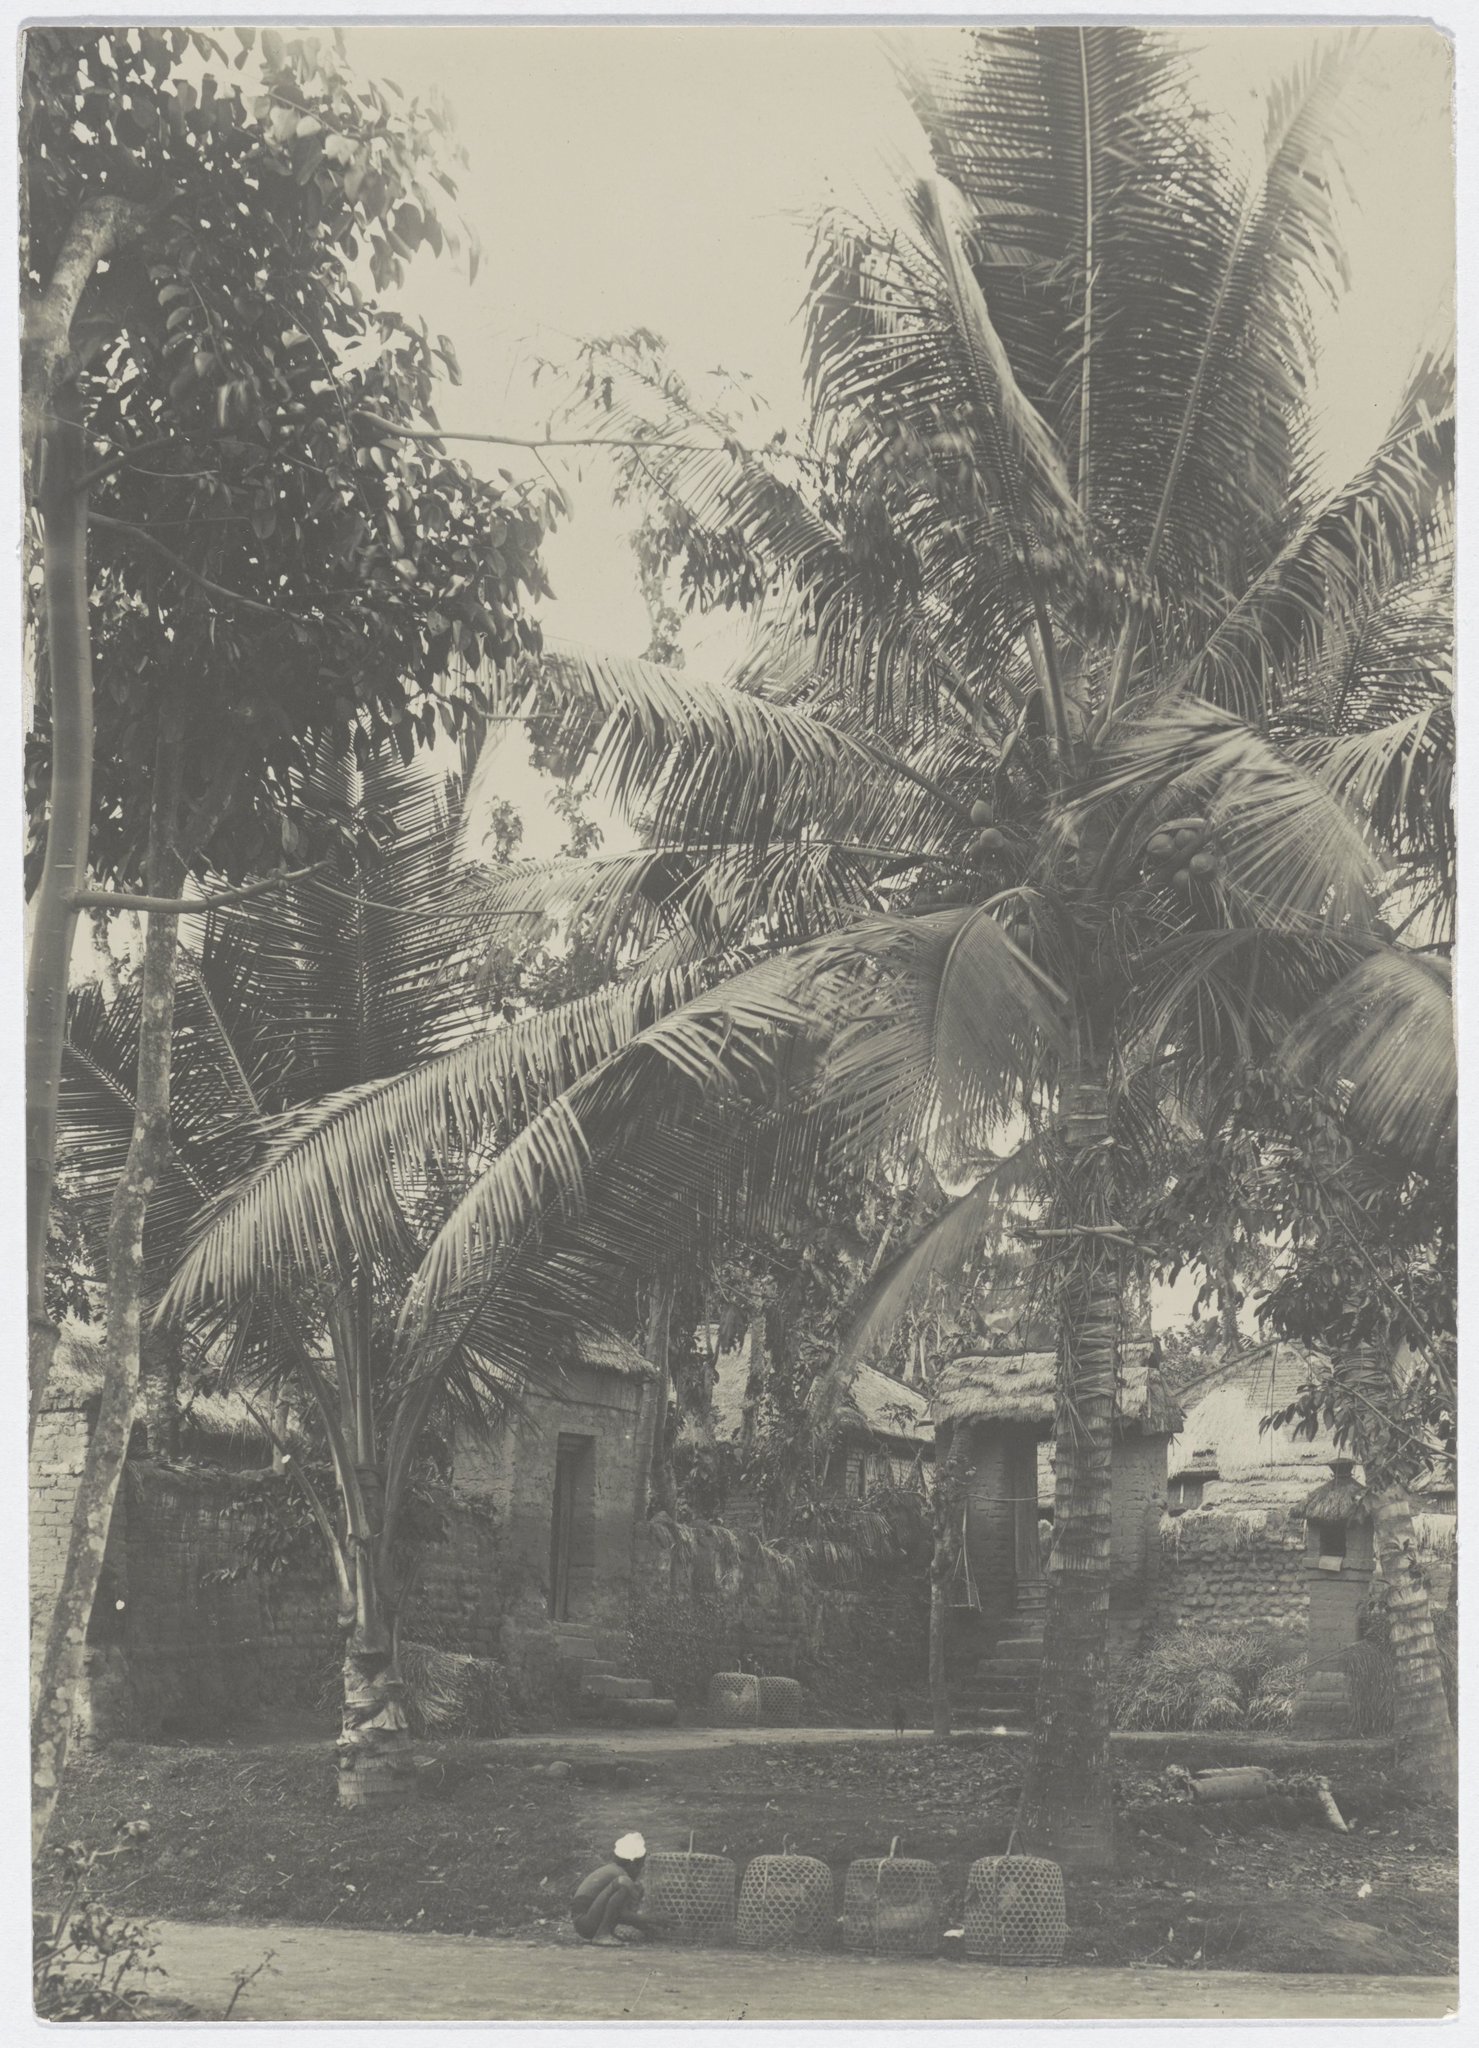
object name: photograph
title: De poort voor een woning op Bali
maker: Anonymous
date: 1890-1915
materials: cardboard, paper, photographic support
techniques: albumen print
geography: indonesia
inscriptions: title: ‘Ingangen van Bal. woningen. Het als duiventilletje uitziende bouwseltje rechts, is de woning van den huisgod. Daarin behoort zich te bevinden miniatuur huisraad, zooals een zeer kleine gendie (?), voor het gebruik van den huisgod.’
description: Rechts naast de poort staat een minituur huis op een paal wat doorgaat als godenhuisje.